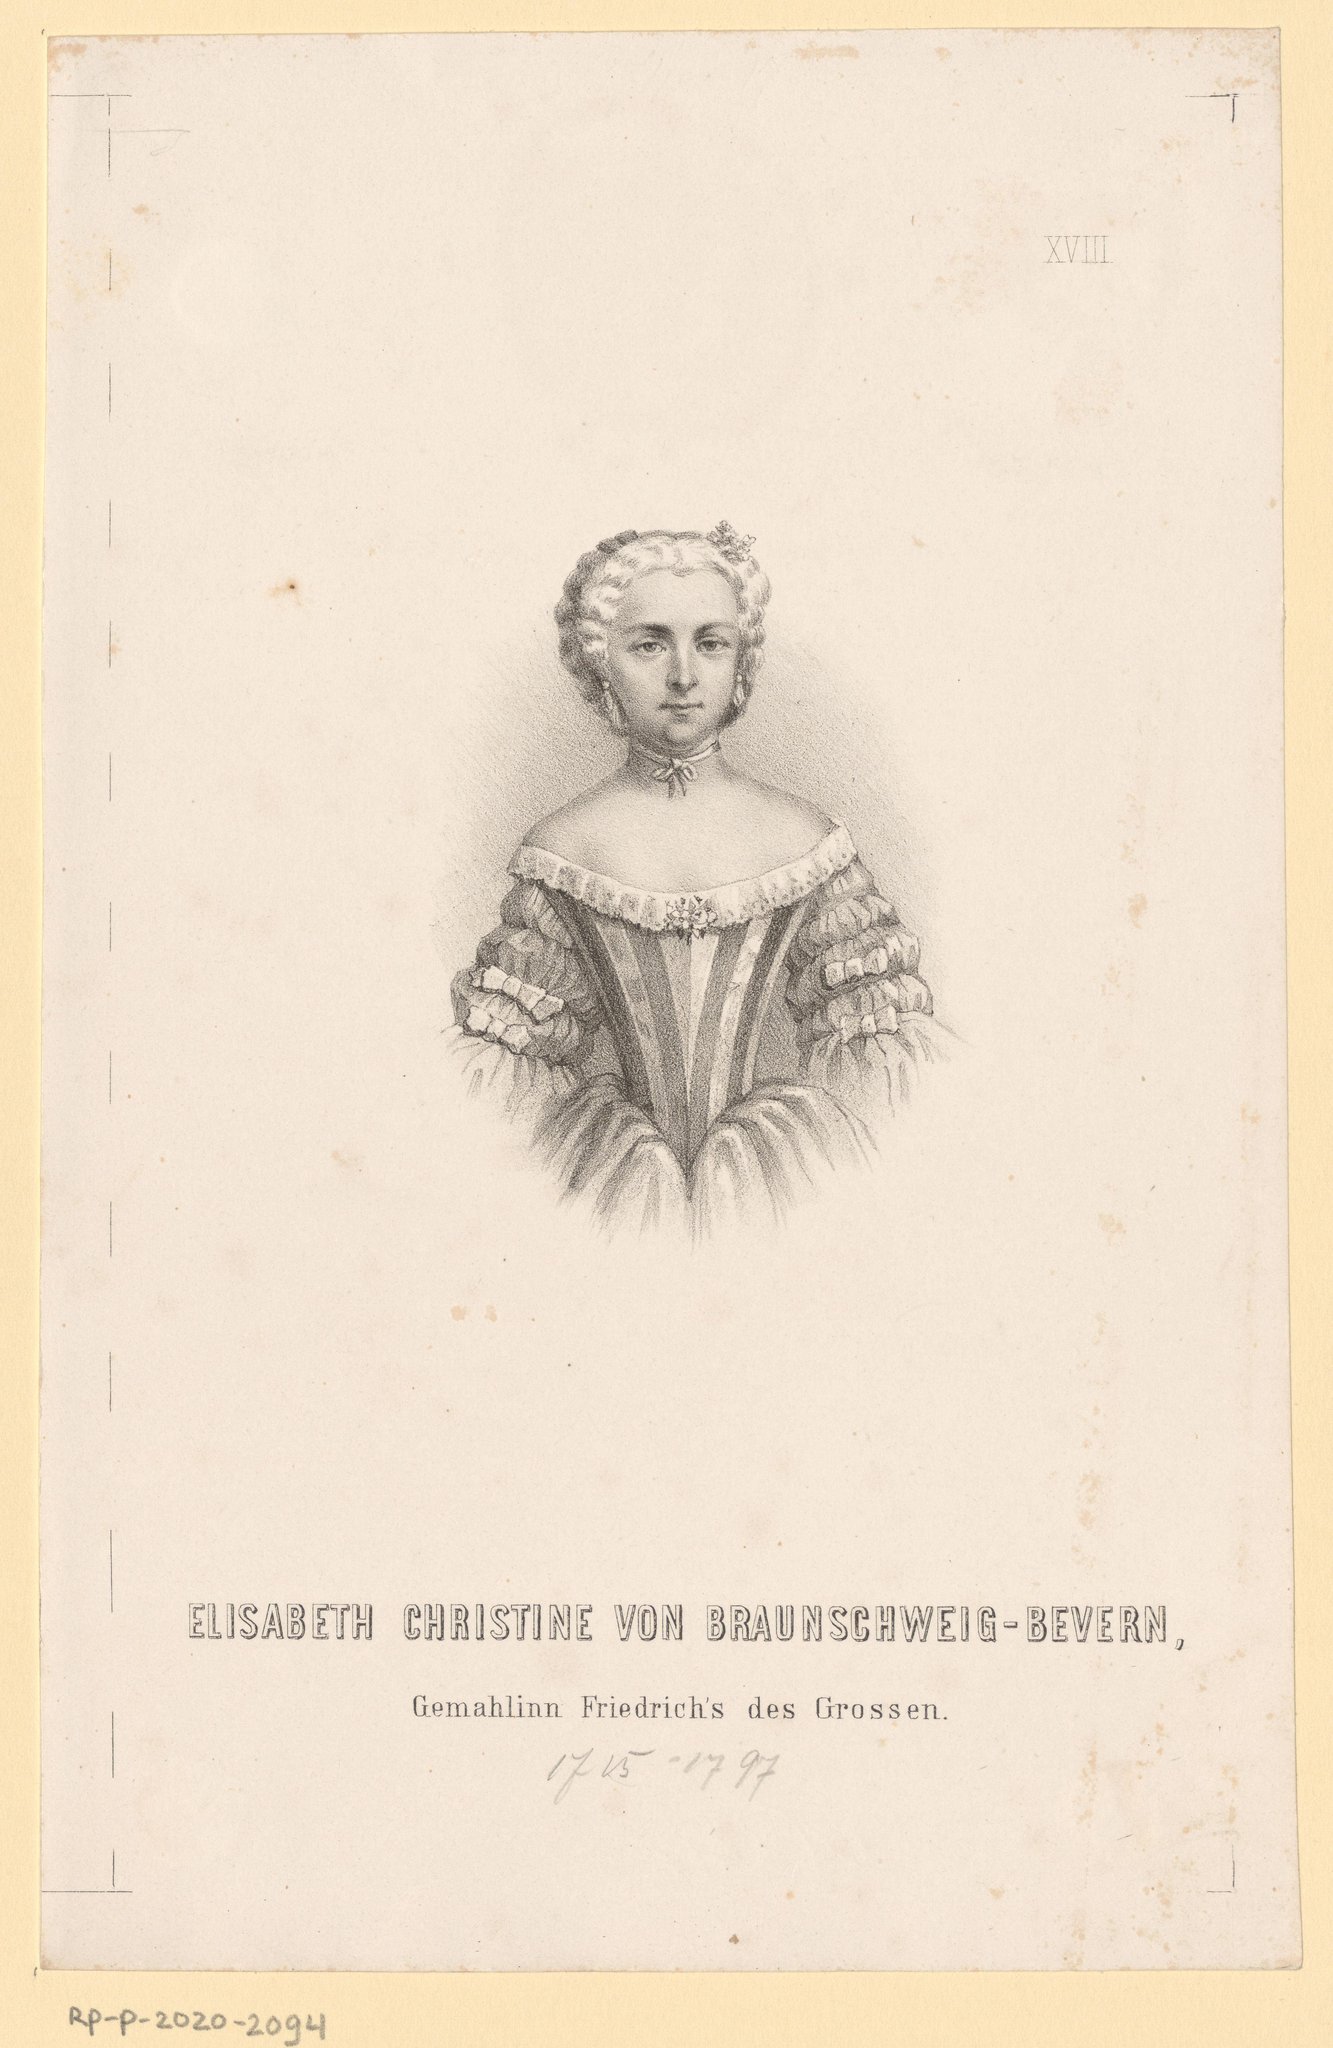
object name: print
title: Portret van Elisabeth Christine van Brunswijk-Bevern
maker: Anonymous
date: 1800-1900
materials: paper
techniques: lithograph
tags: historical persons - bb - woman